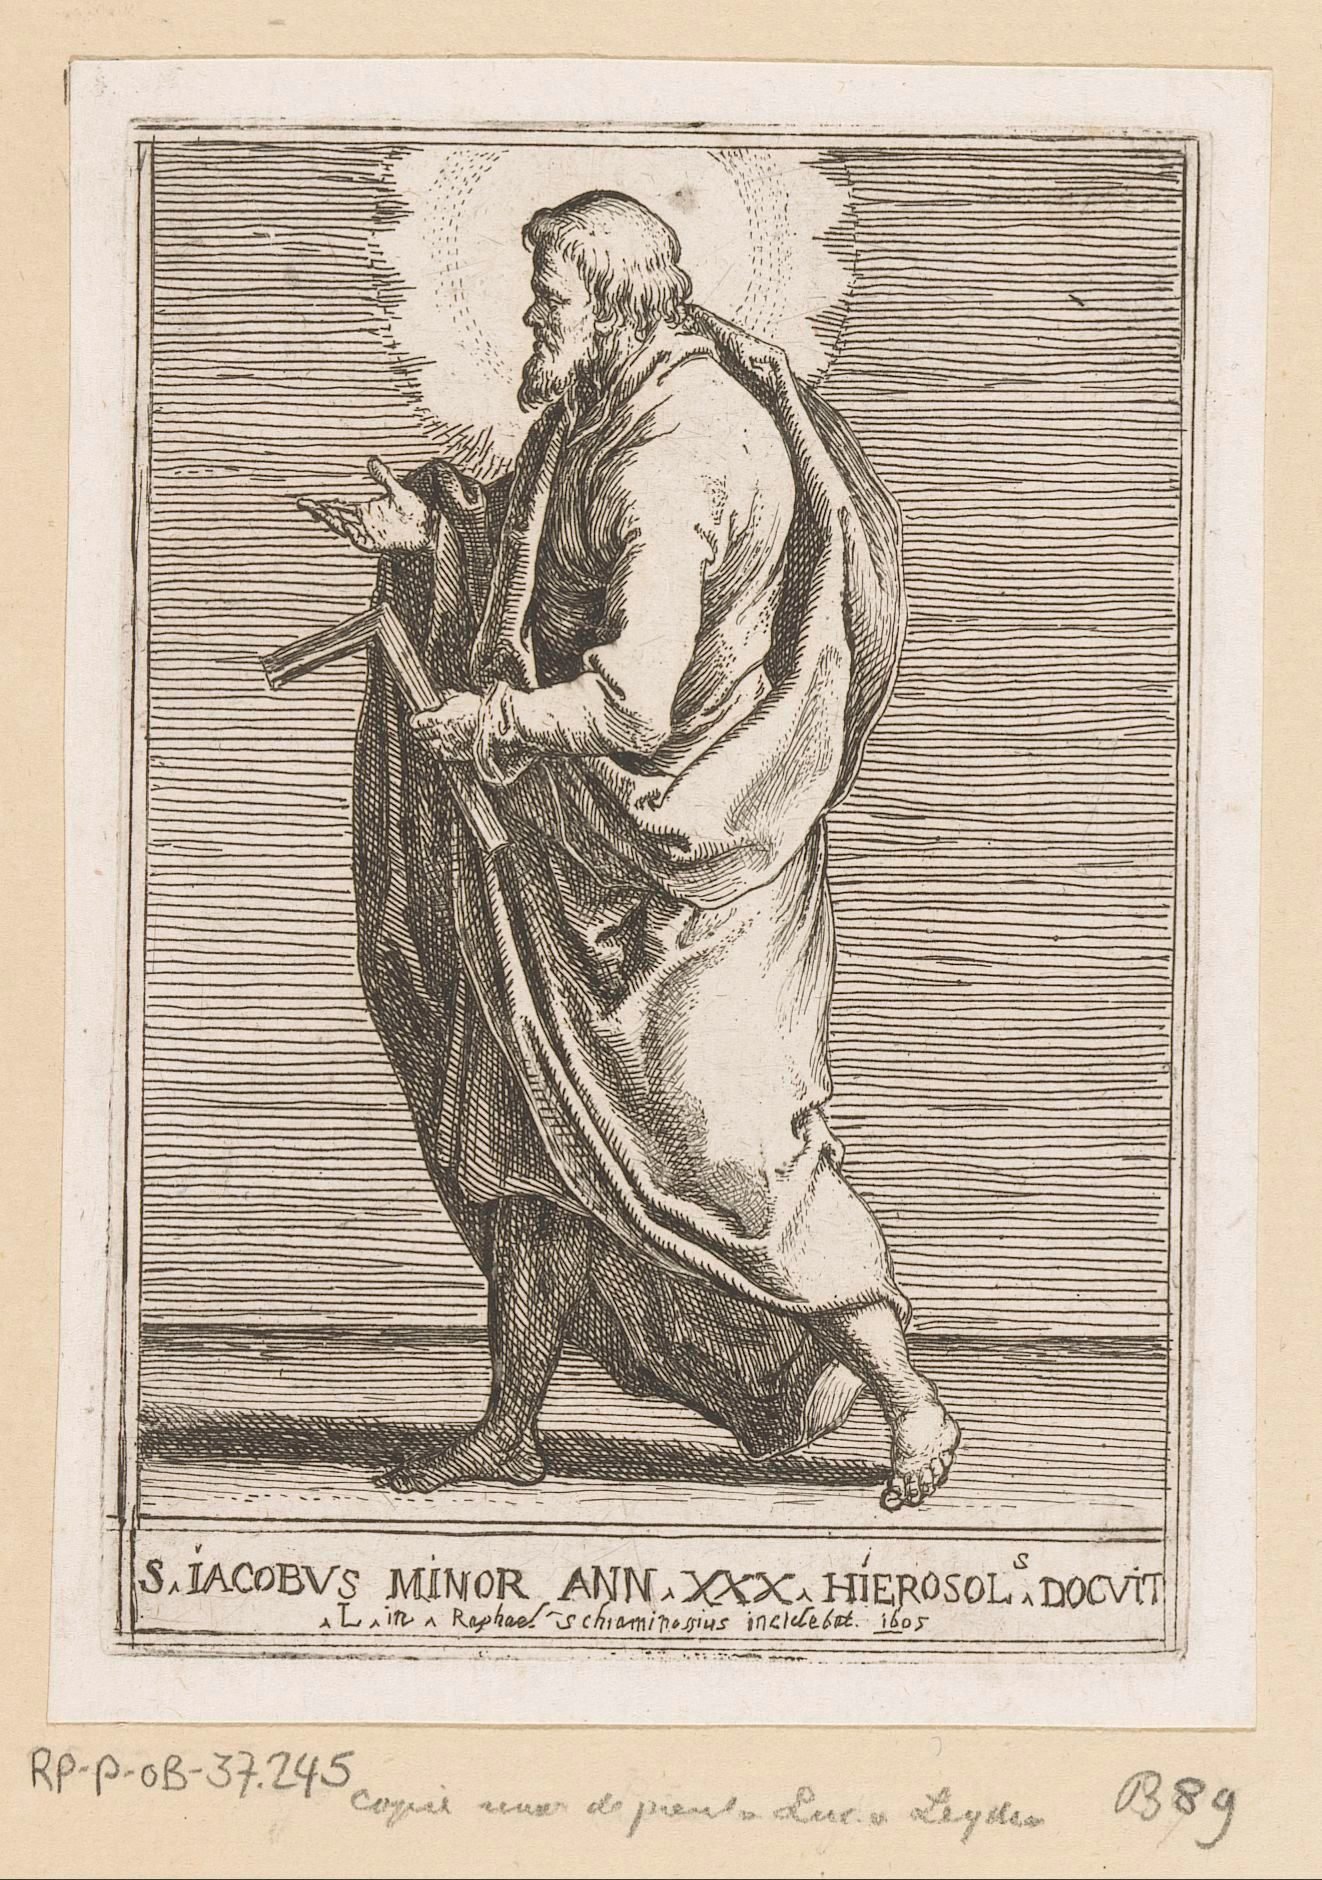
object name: print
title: Heilige Jakobus de Mindere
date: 1605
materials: paper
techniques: etching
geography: italy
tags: the apostle james the less, first bishop of jerusalem; possible attributes: book, fuller's club, scroll, measuring-instruments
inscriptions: collector's mark: Lugt 240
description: De heilige Jakobus de Mindere staand met een meetinstrument in de hand.